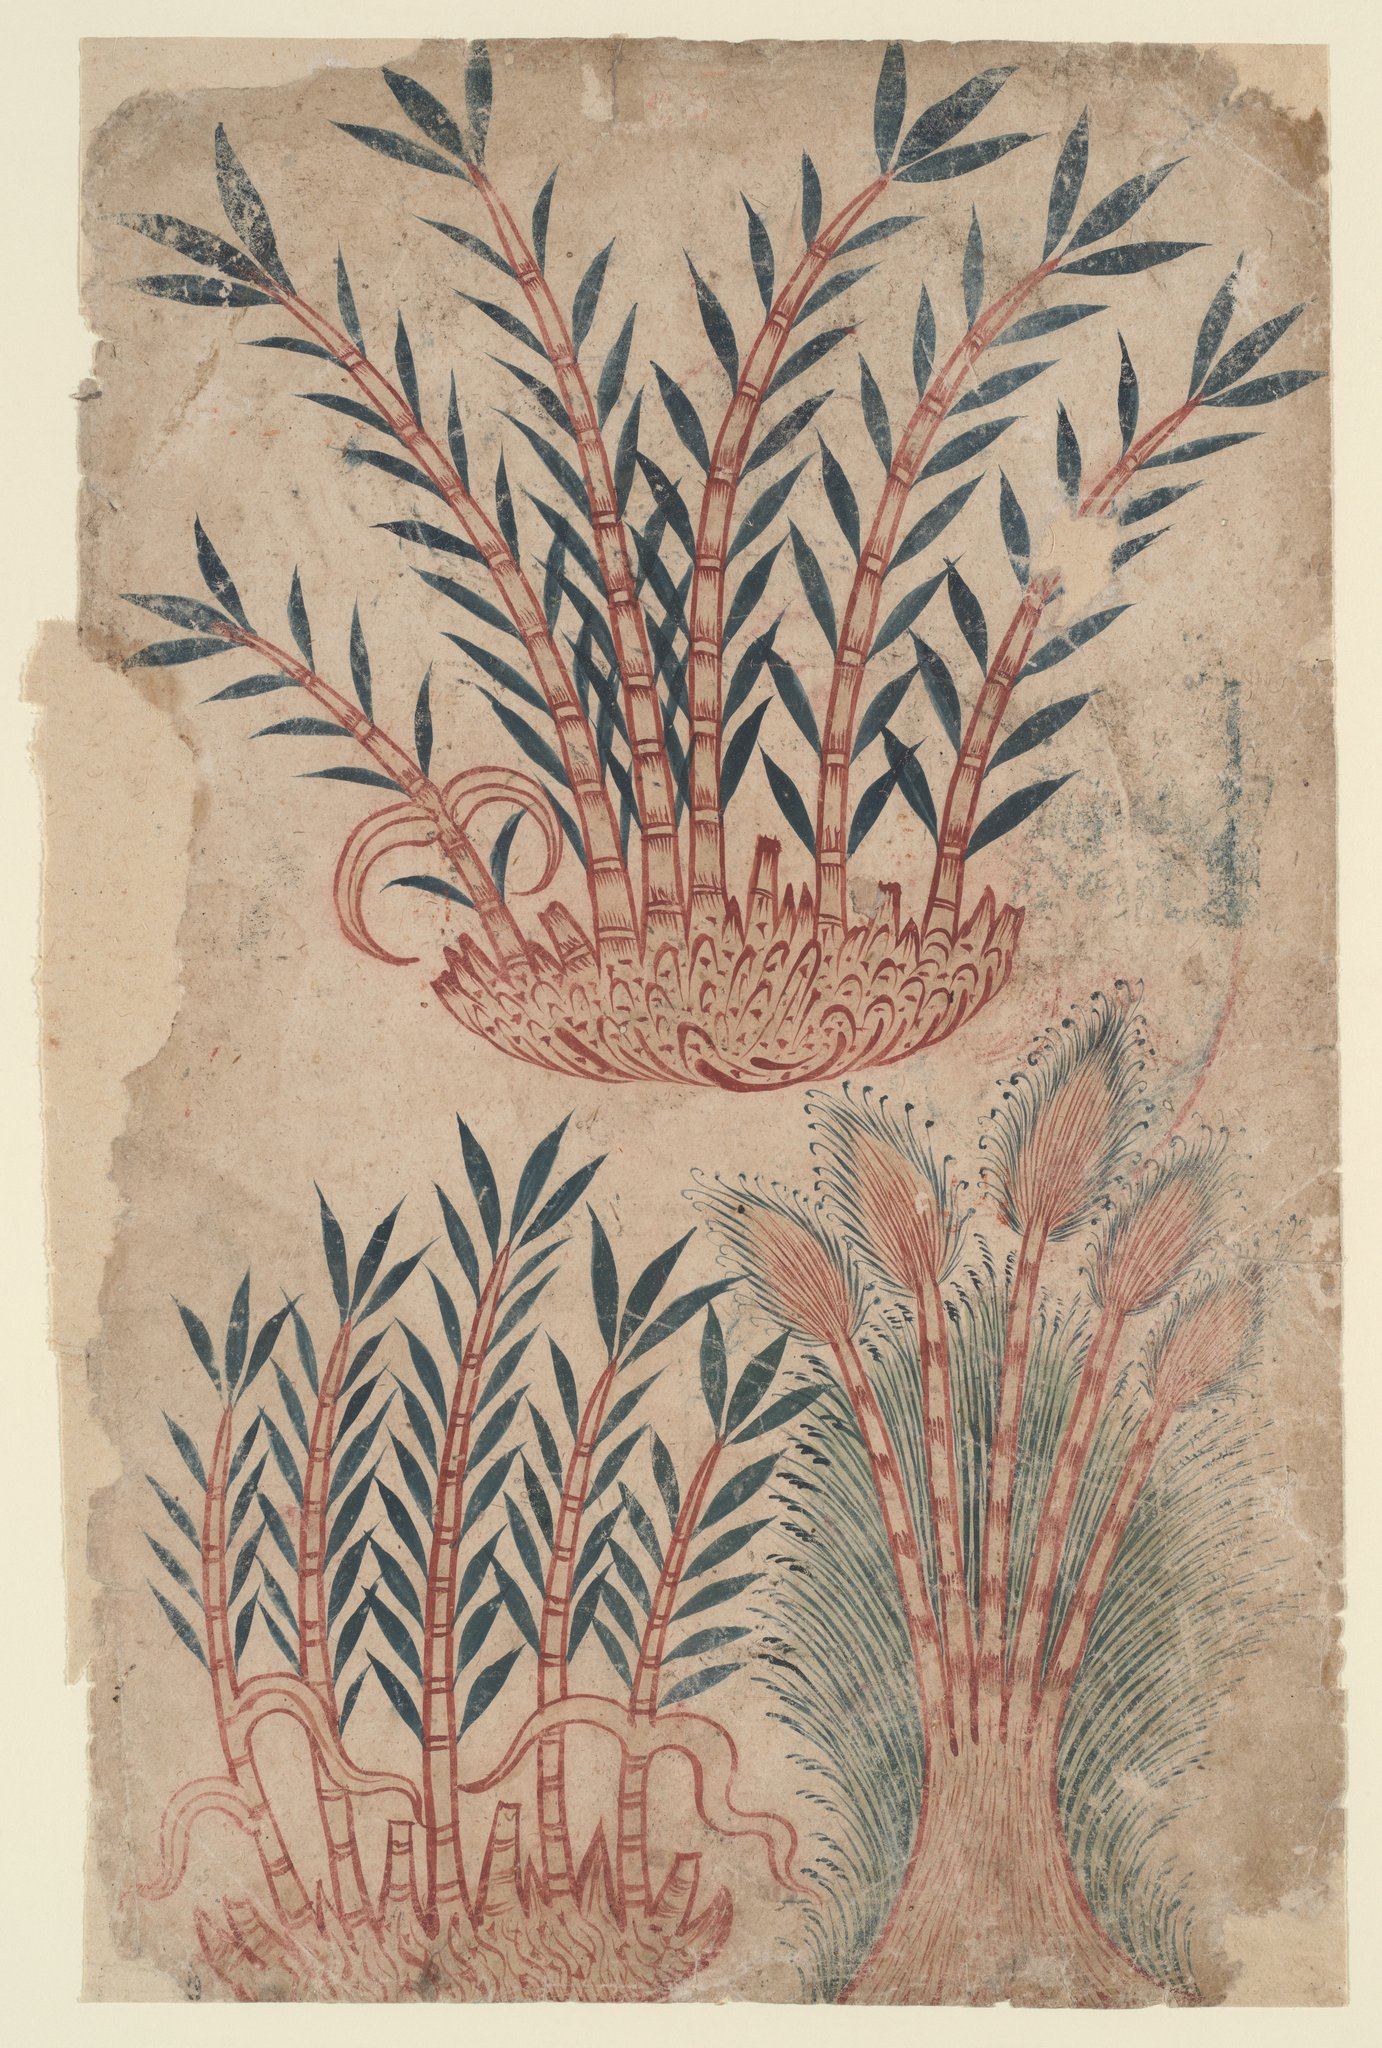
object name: folio from an illustrated manuscript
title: "ThreeTypes of Reeds," Folio from a De Materia Medica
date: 1595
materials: paper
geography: india